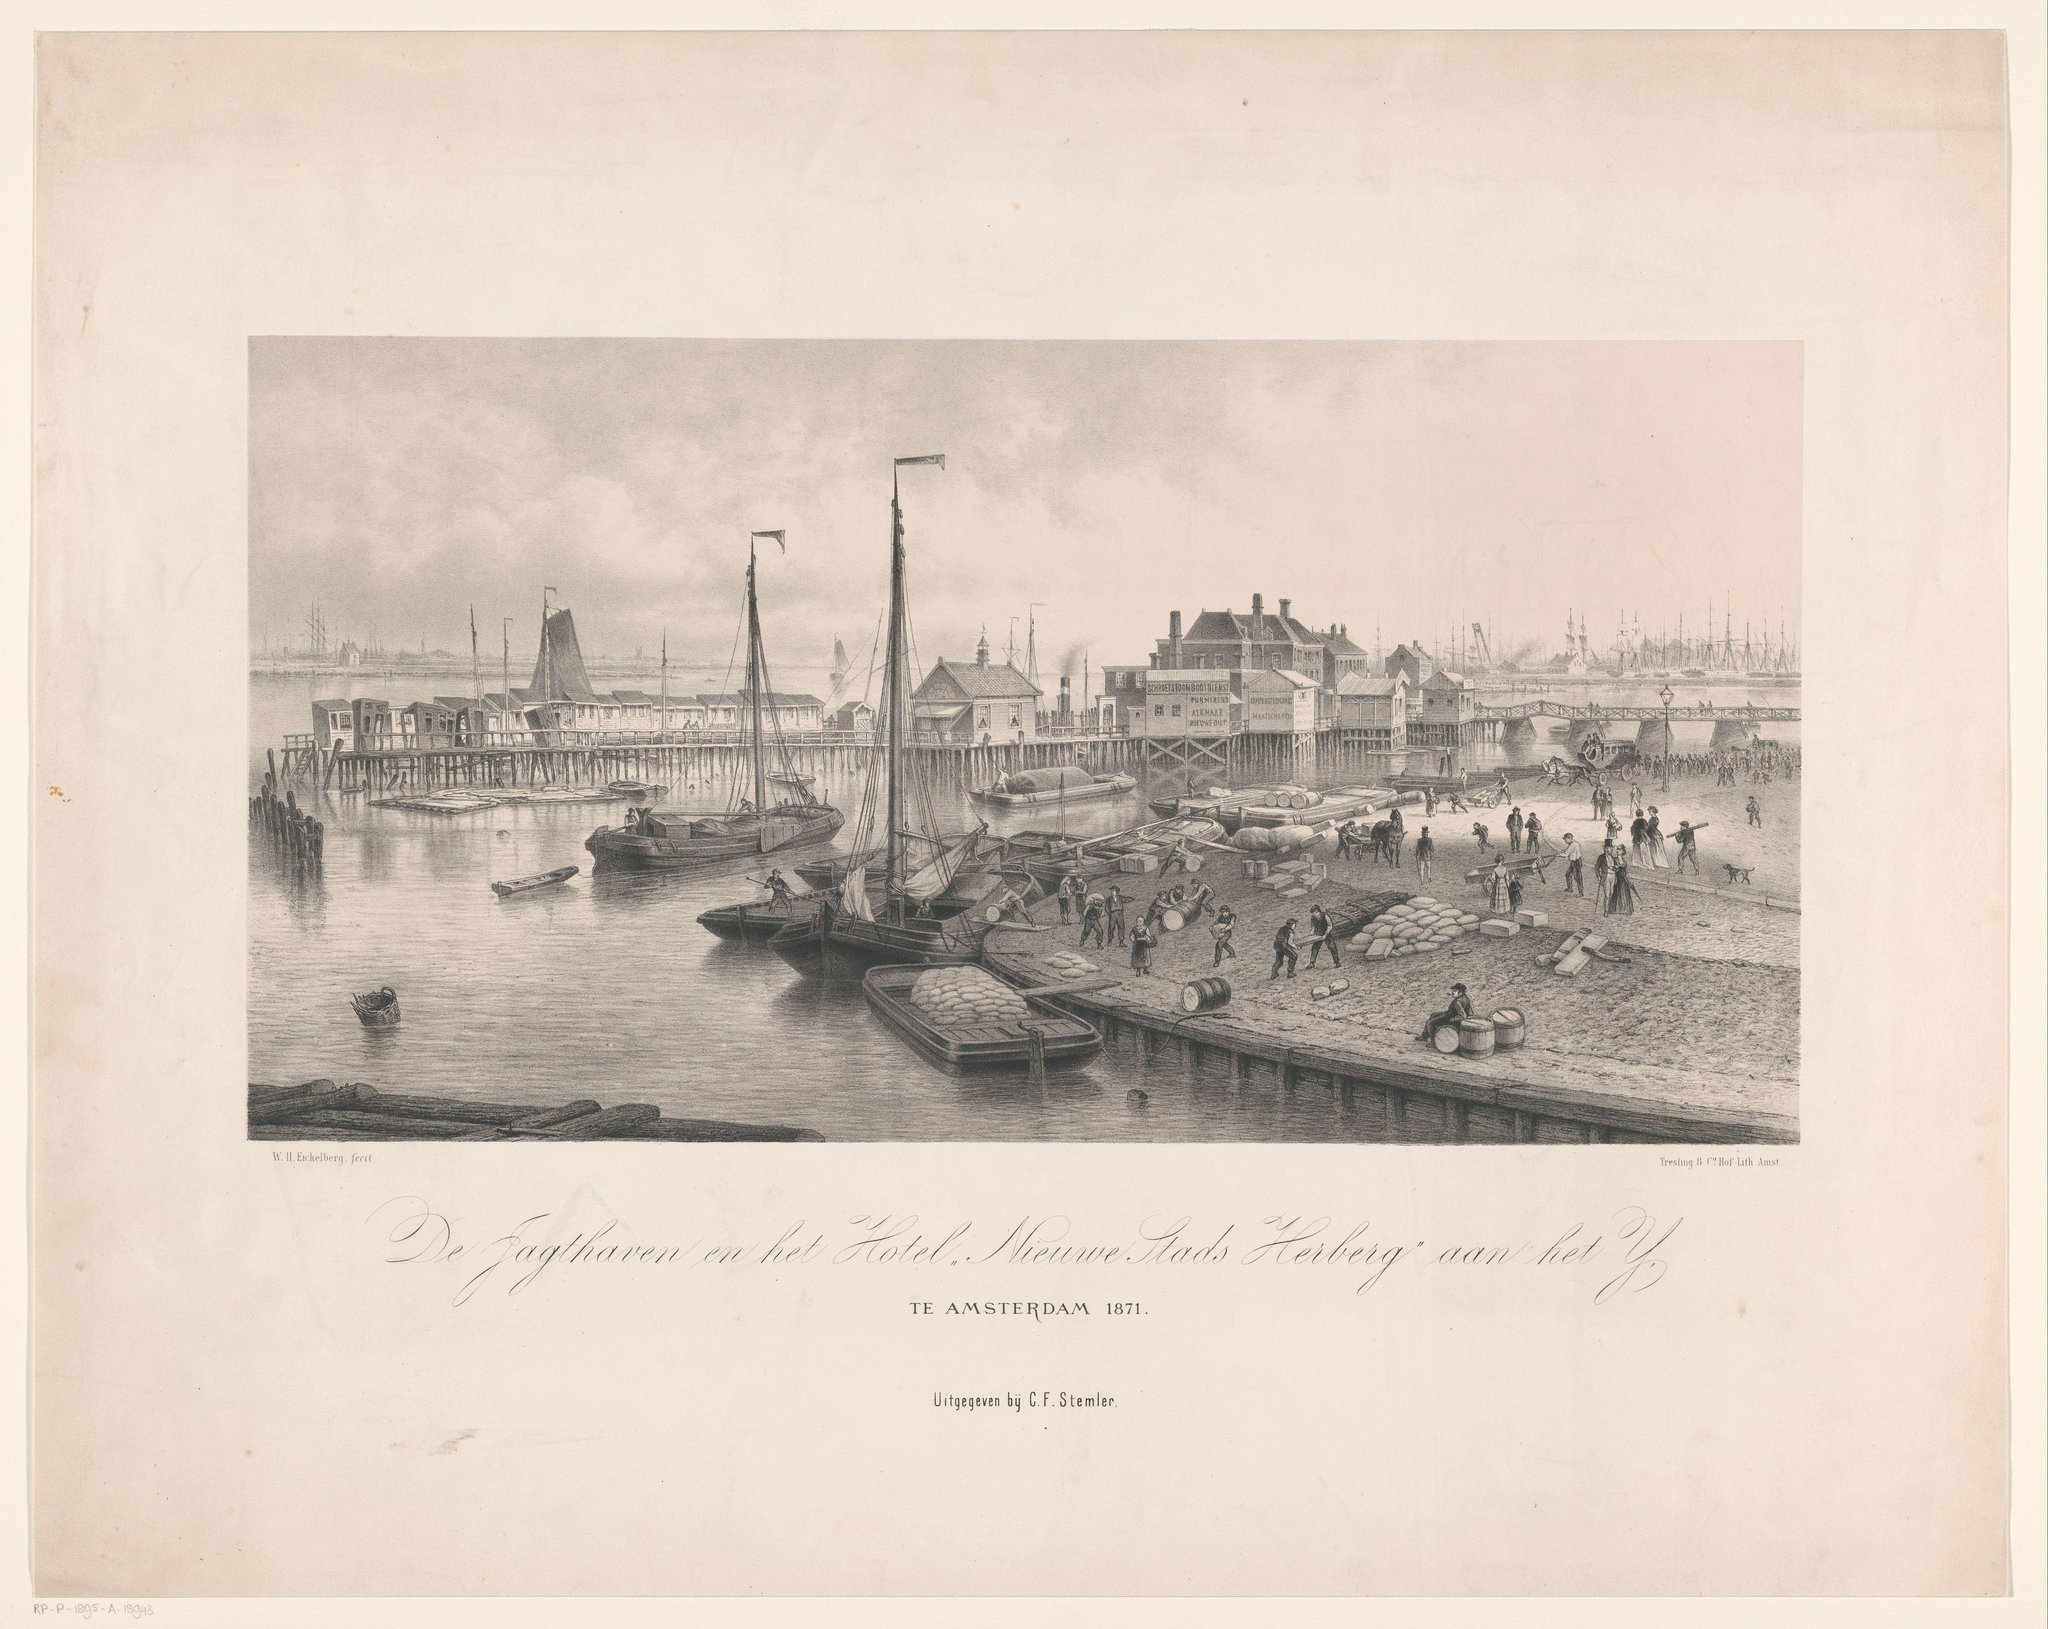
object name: print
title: De Jagthaven en het Hotel "Nieuwe Stads Herberg" aan het IJ, te Amsterdam 1871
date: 1871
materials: paper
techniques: lithograph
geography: netherlands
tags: pier, quay, wharf, hotel, hostelry, inn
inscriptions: collector's mark: Lugt 2228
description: Het IJ gezien vanaf het Korte Singel met rechts de haringpakkerij waar schepen worden geladen en gelost. Daarachter de Nieuwe Stadsherberg kort voor de sloop. In de achtergrond links de toren van Ransdorp, rechts het Oosterdok.